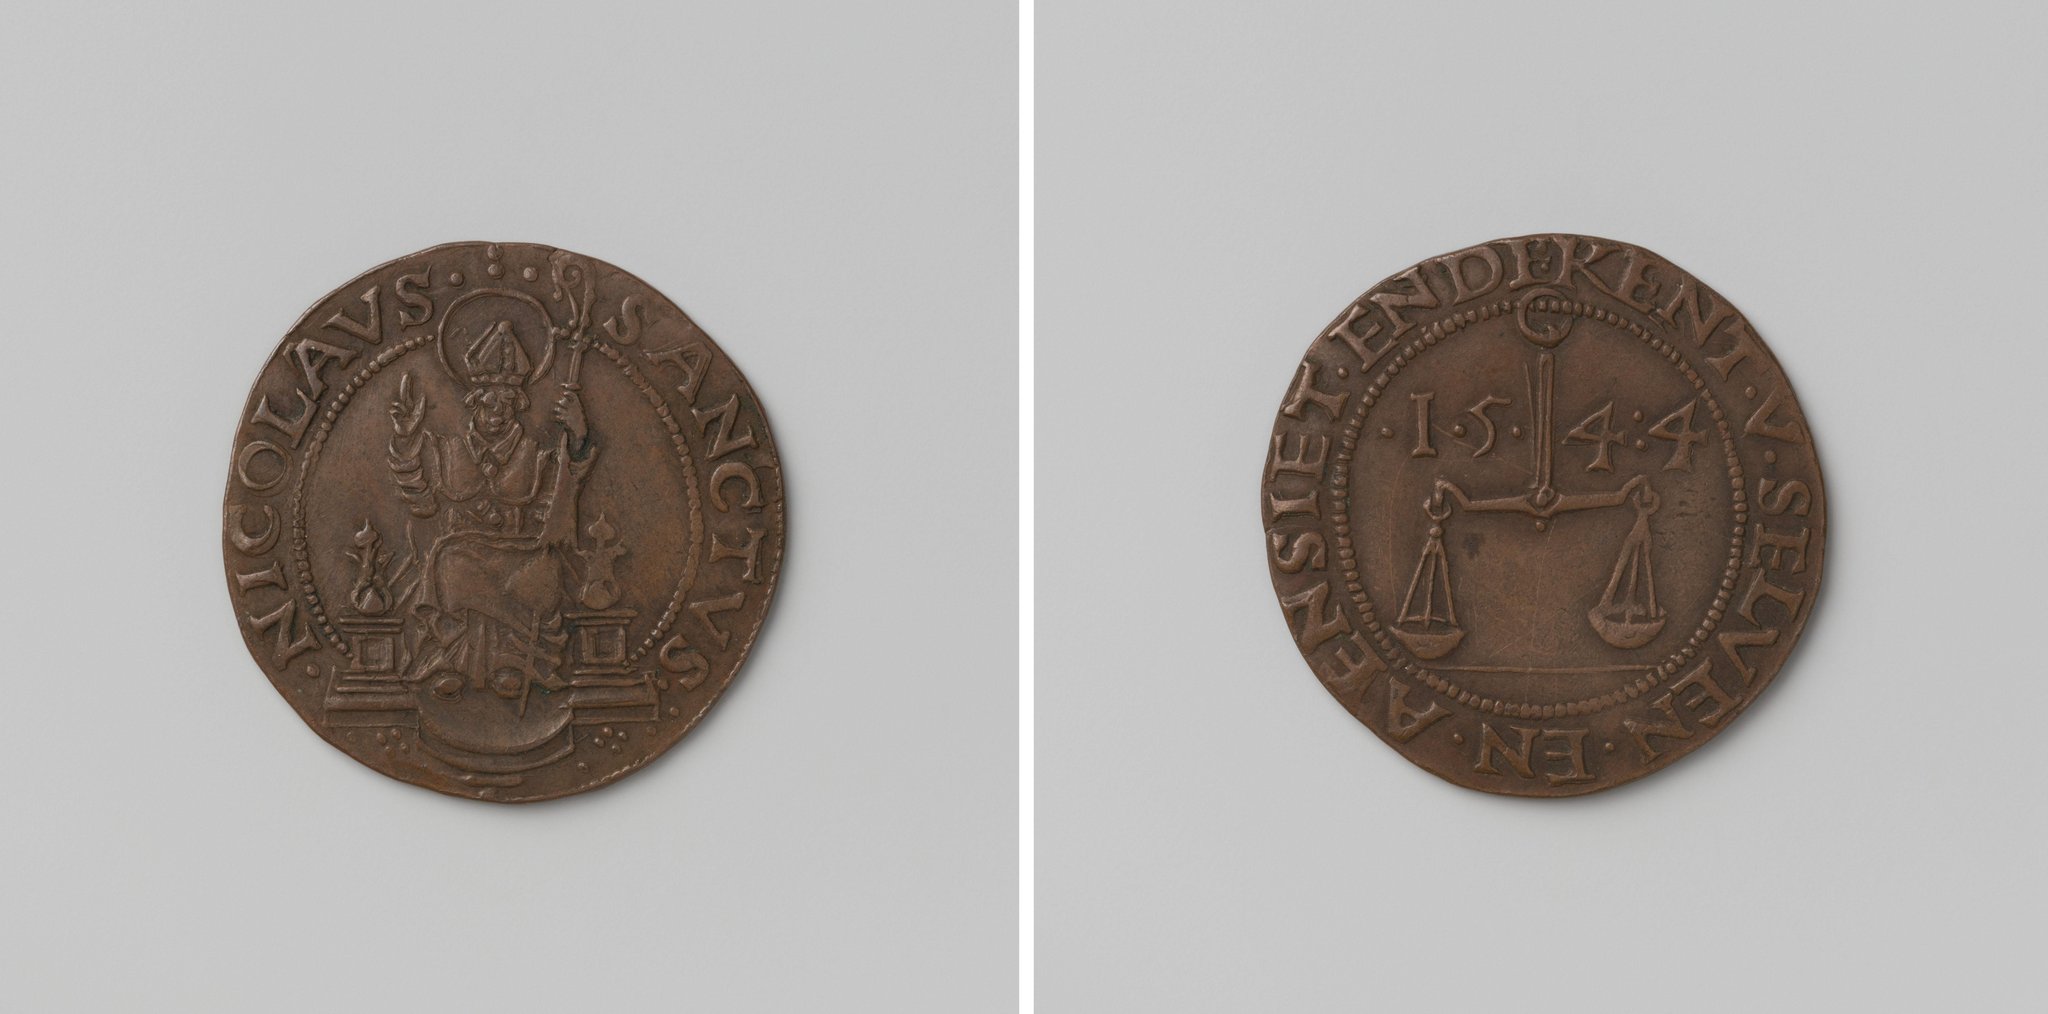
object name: medal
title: Sint Nicolaas- of kramersgilde van Antwerpen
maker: Anonymous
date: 1544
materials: copper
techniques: striking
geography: antwerp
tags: antwerp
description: Koperen penning. Voorzijde: zittende St. Nicolaas met mijter op hoofd, houdt bisschopsstaf in linkerhand en maakt met rechterhand zegenend gebaar binnen omschrift. Keerzijde: in evenwicht hangende weegschaal tussen jaartal binnen omschrift